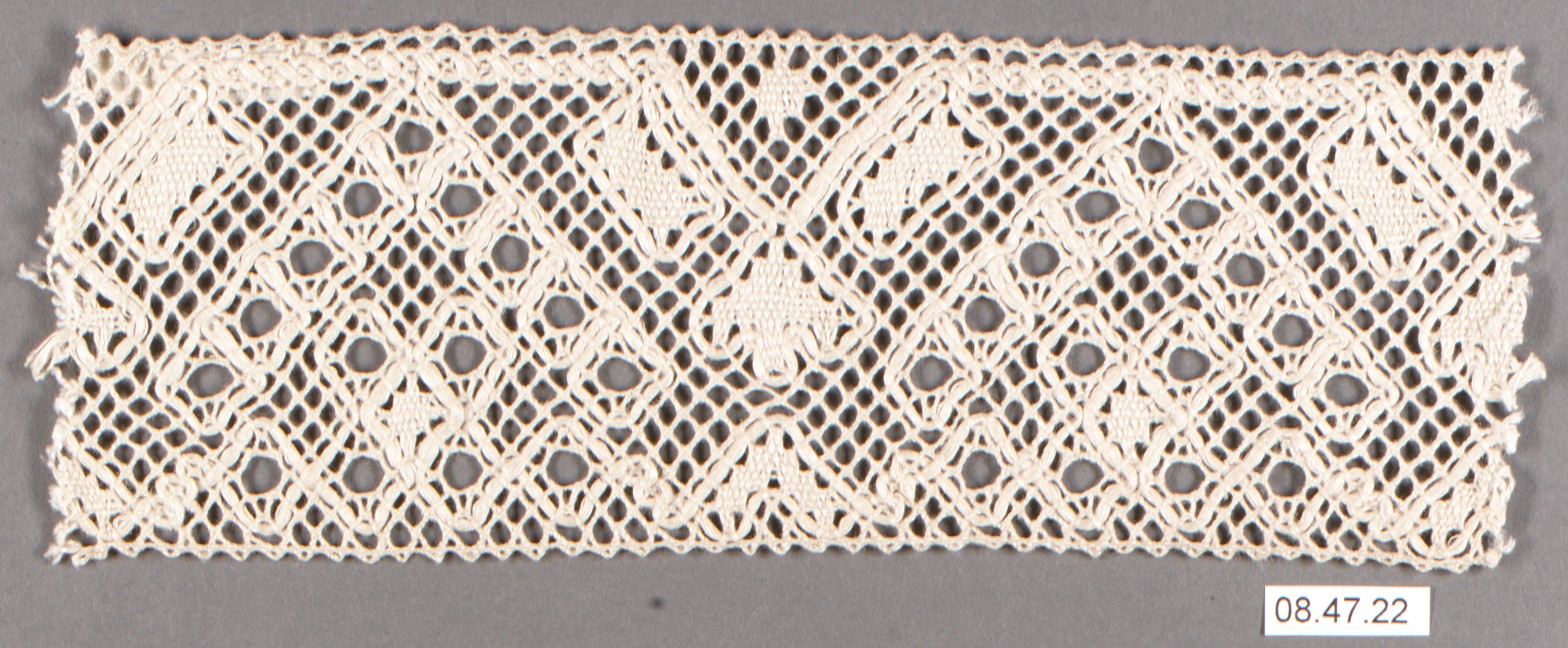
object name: fragment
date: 1801-1900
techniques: lace